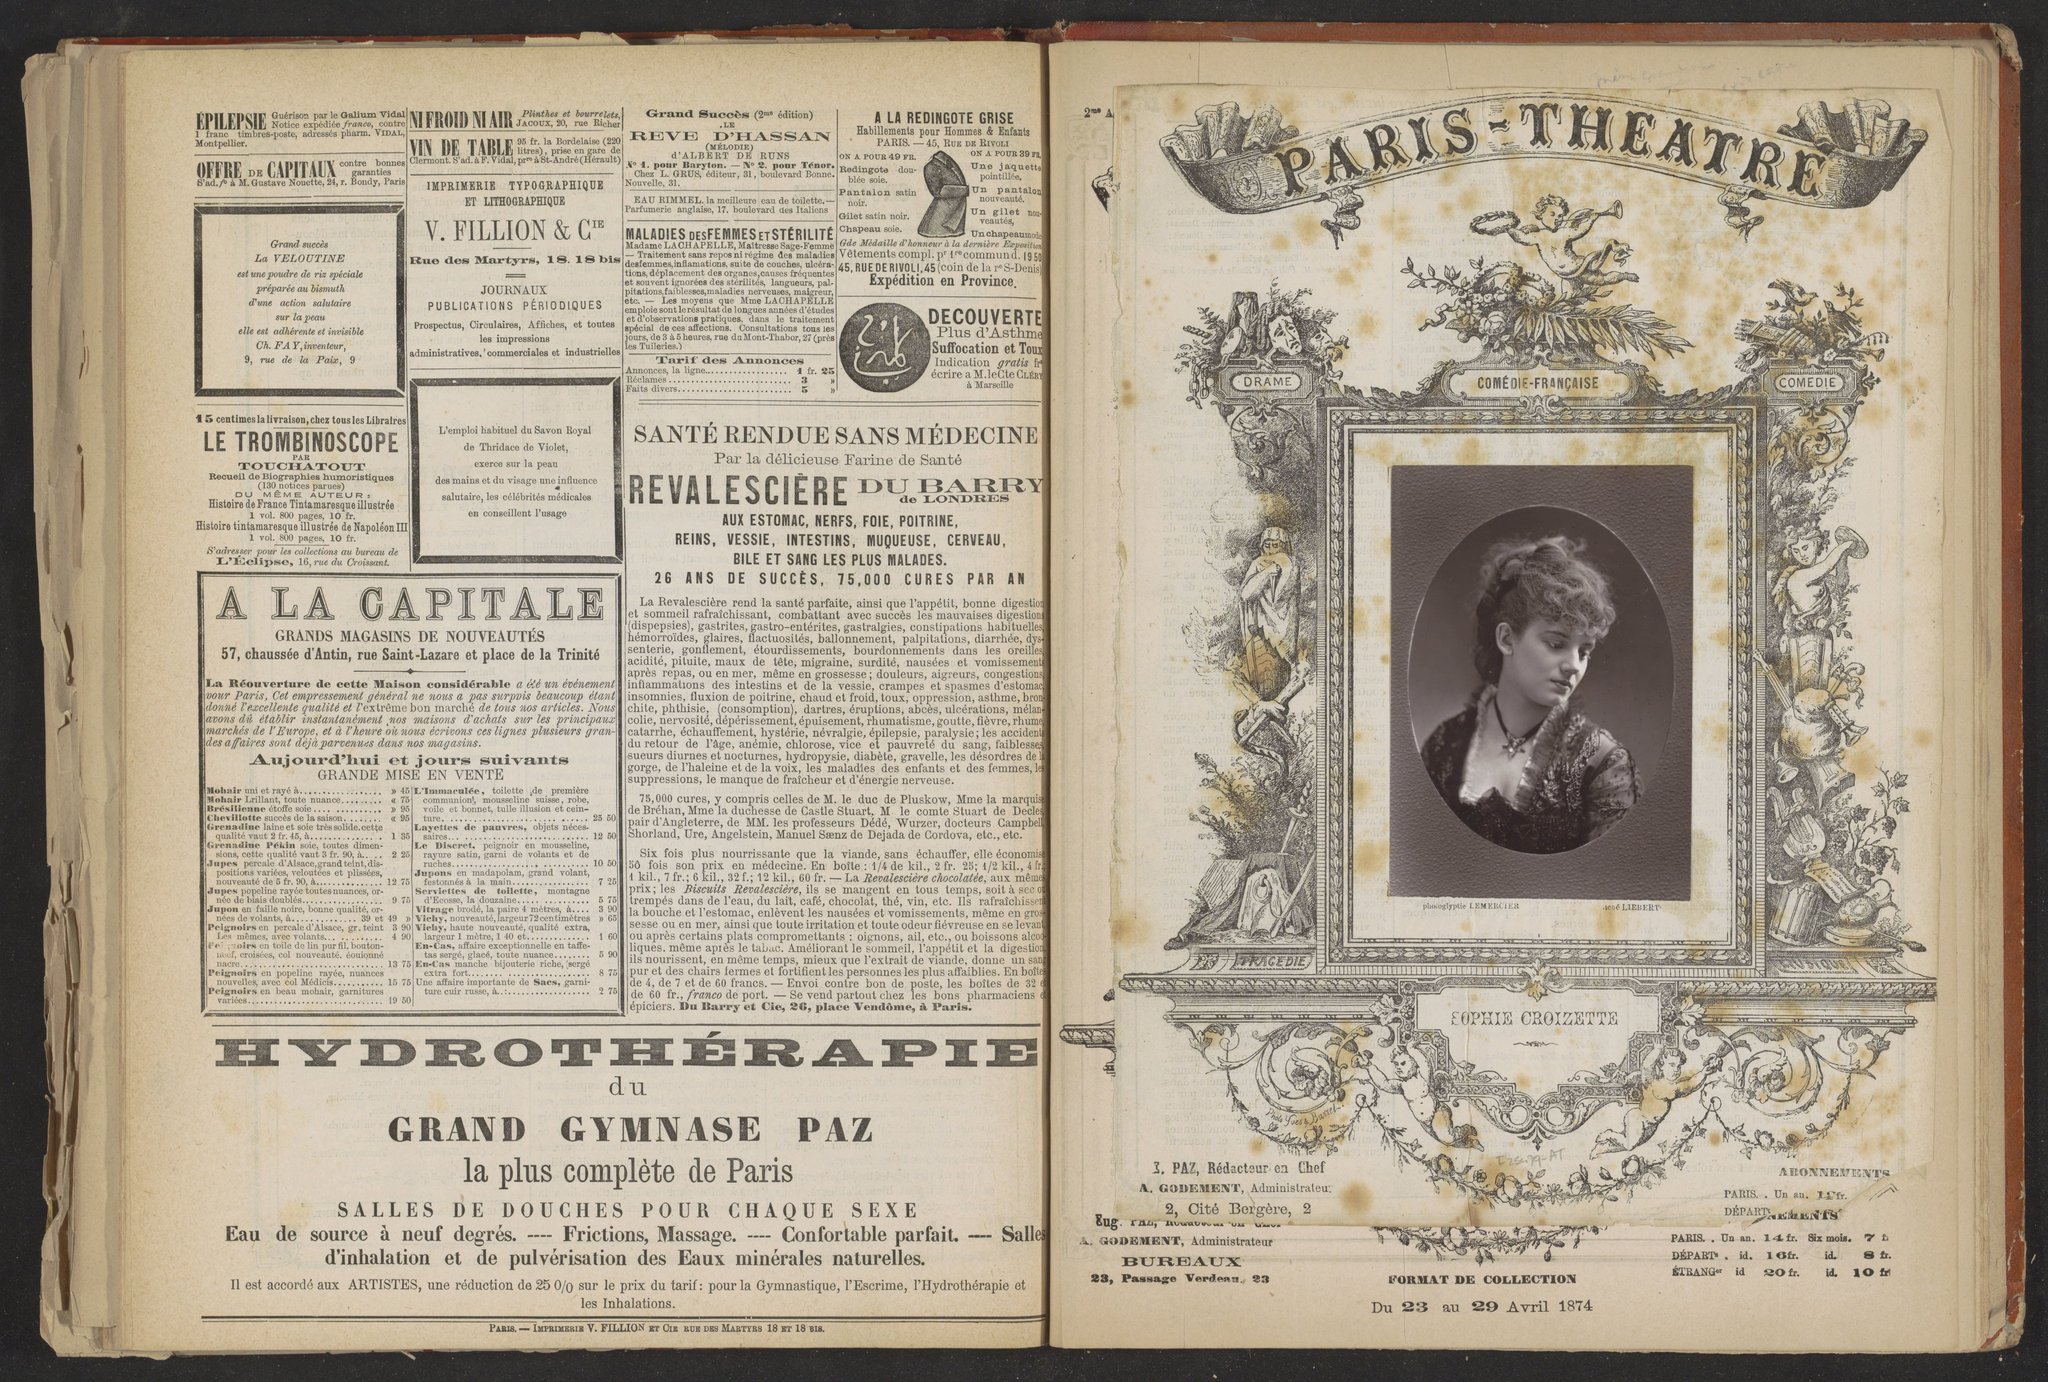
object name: page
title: Sophie Croizette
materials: paper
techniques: woodburytype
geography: france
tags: portrait of actor, actress